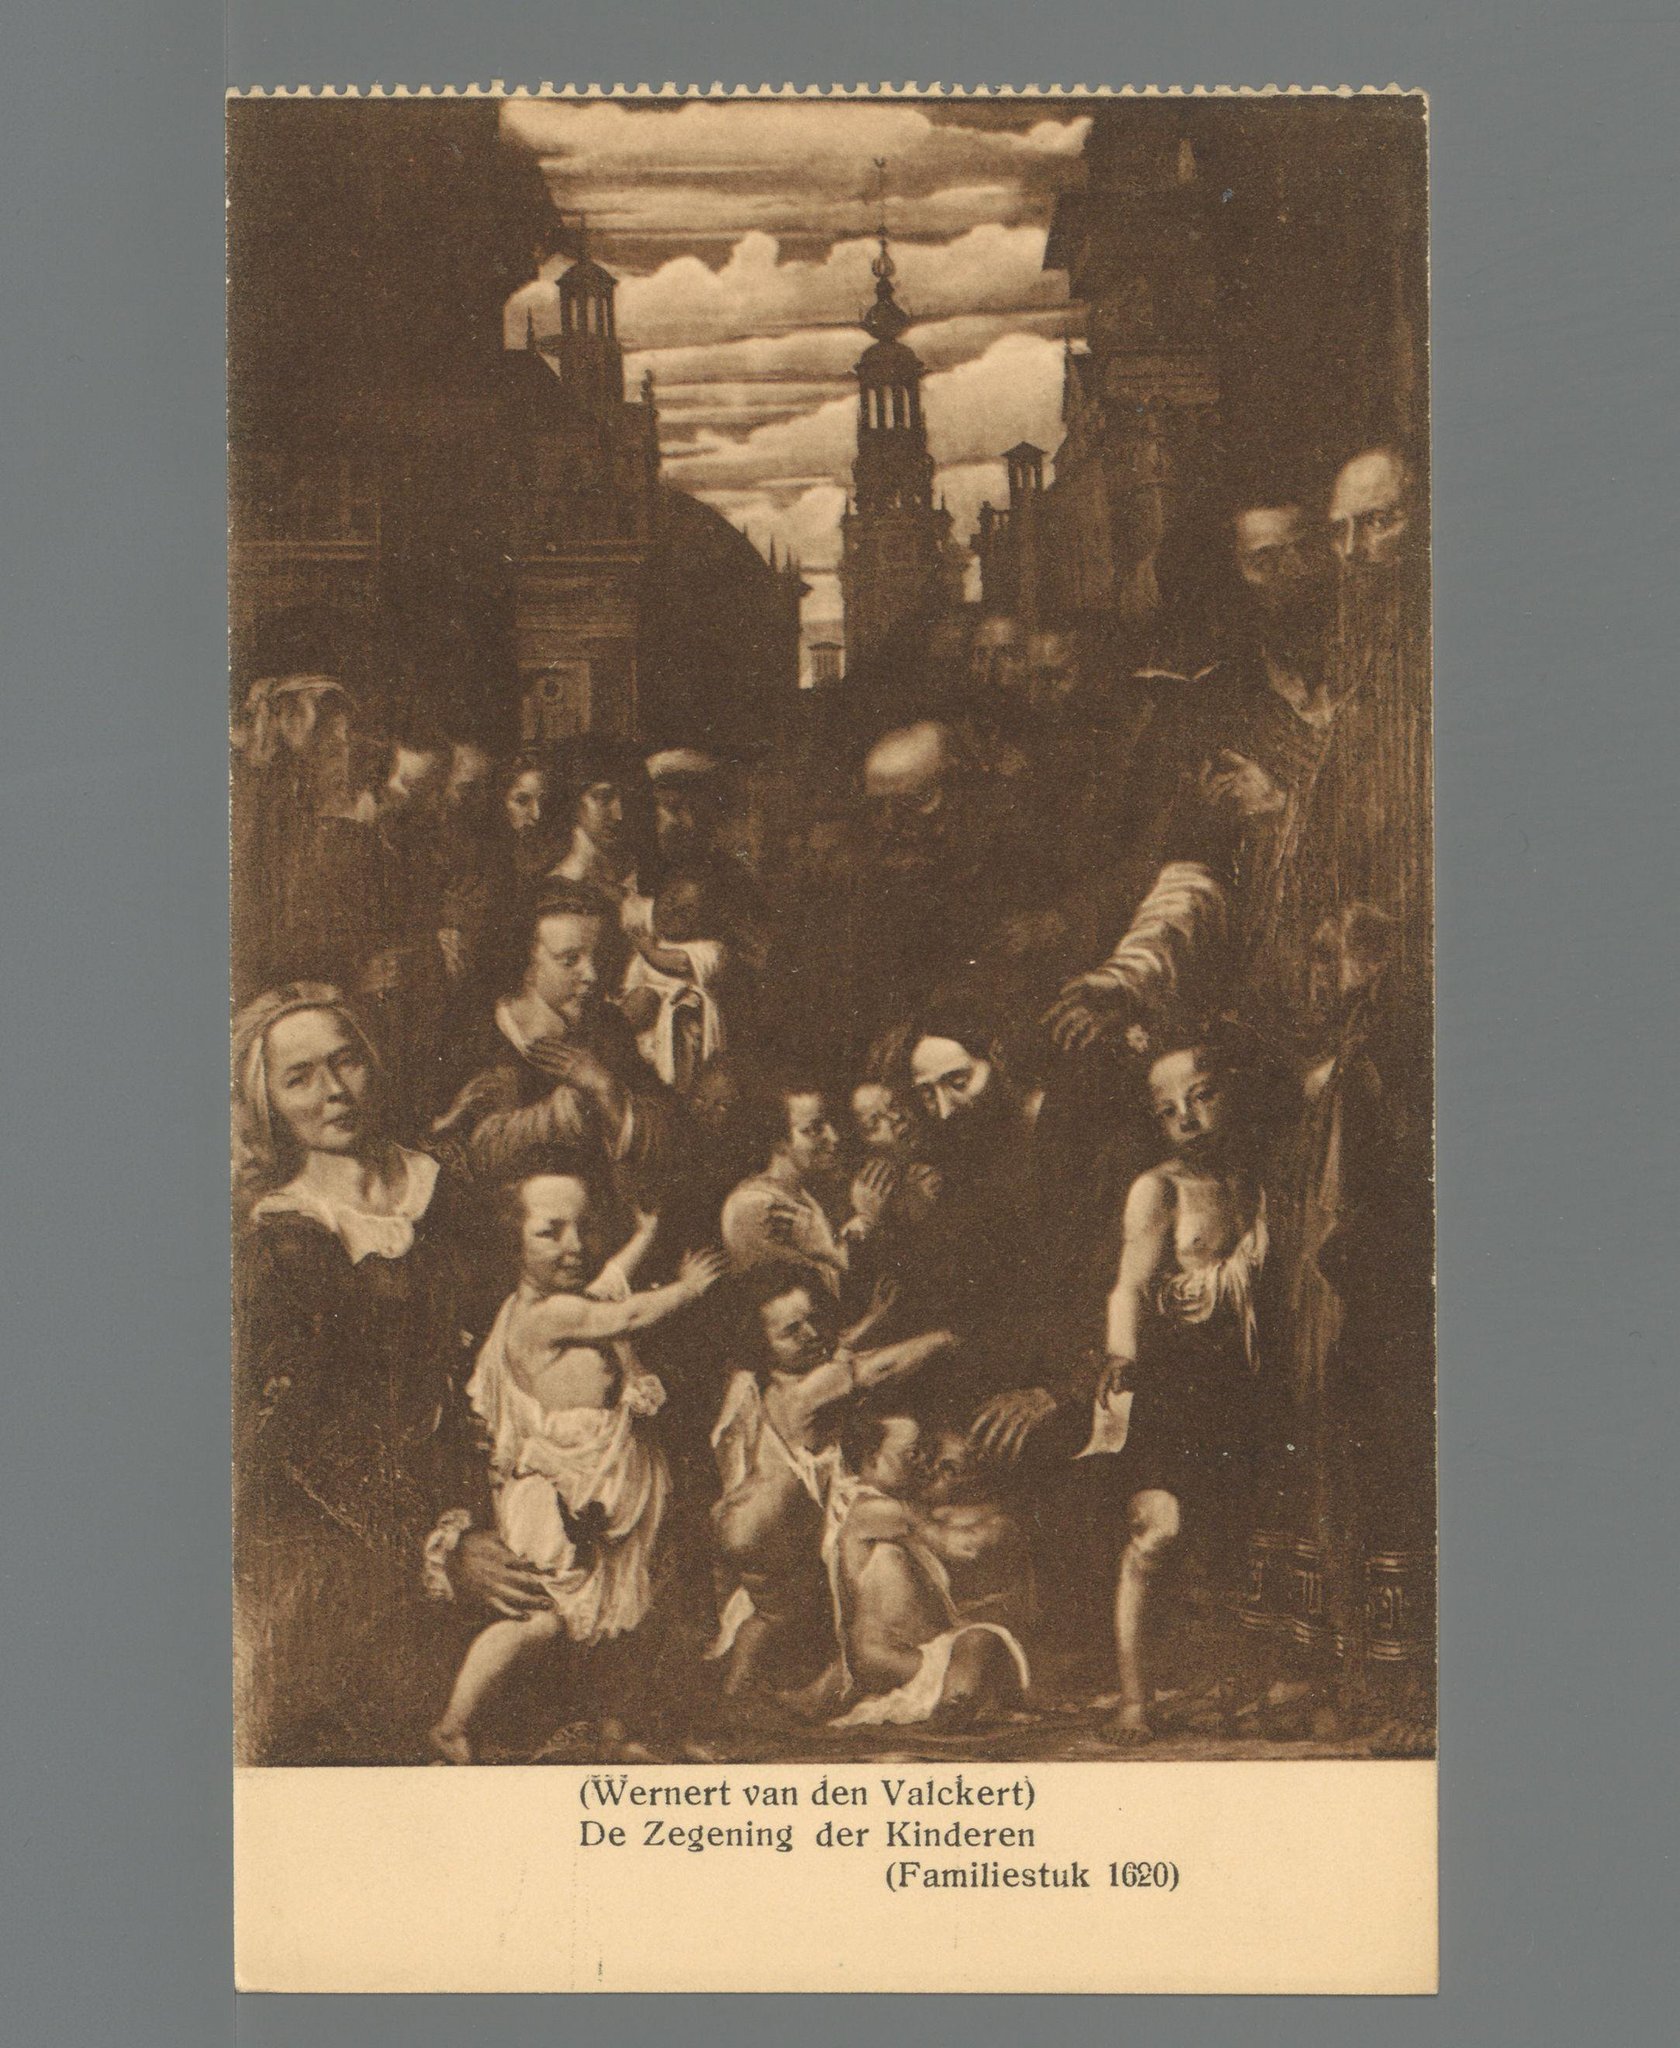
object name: photomechanical print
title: (Wernert van den Valckert). De zegening der kinderen. (Familiestuk 1620)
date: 1908-1921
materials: cardboard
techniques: photograph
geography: rotterdam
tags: permanent exhibition, museum, picture, painting